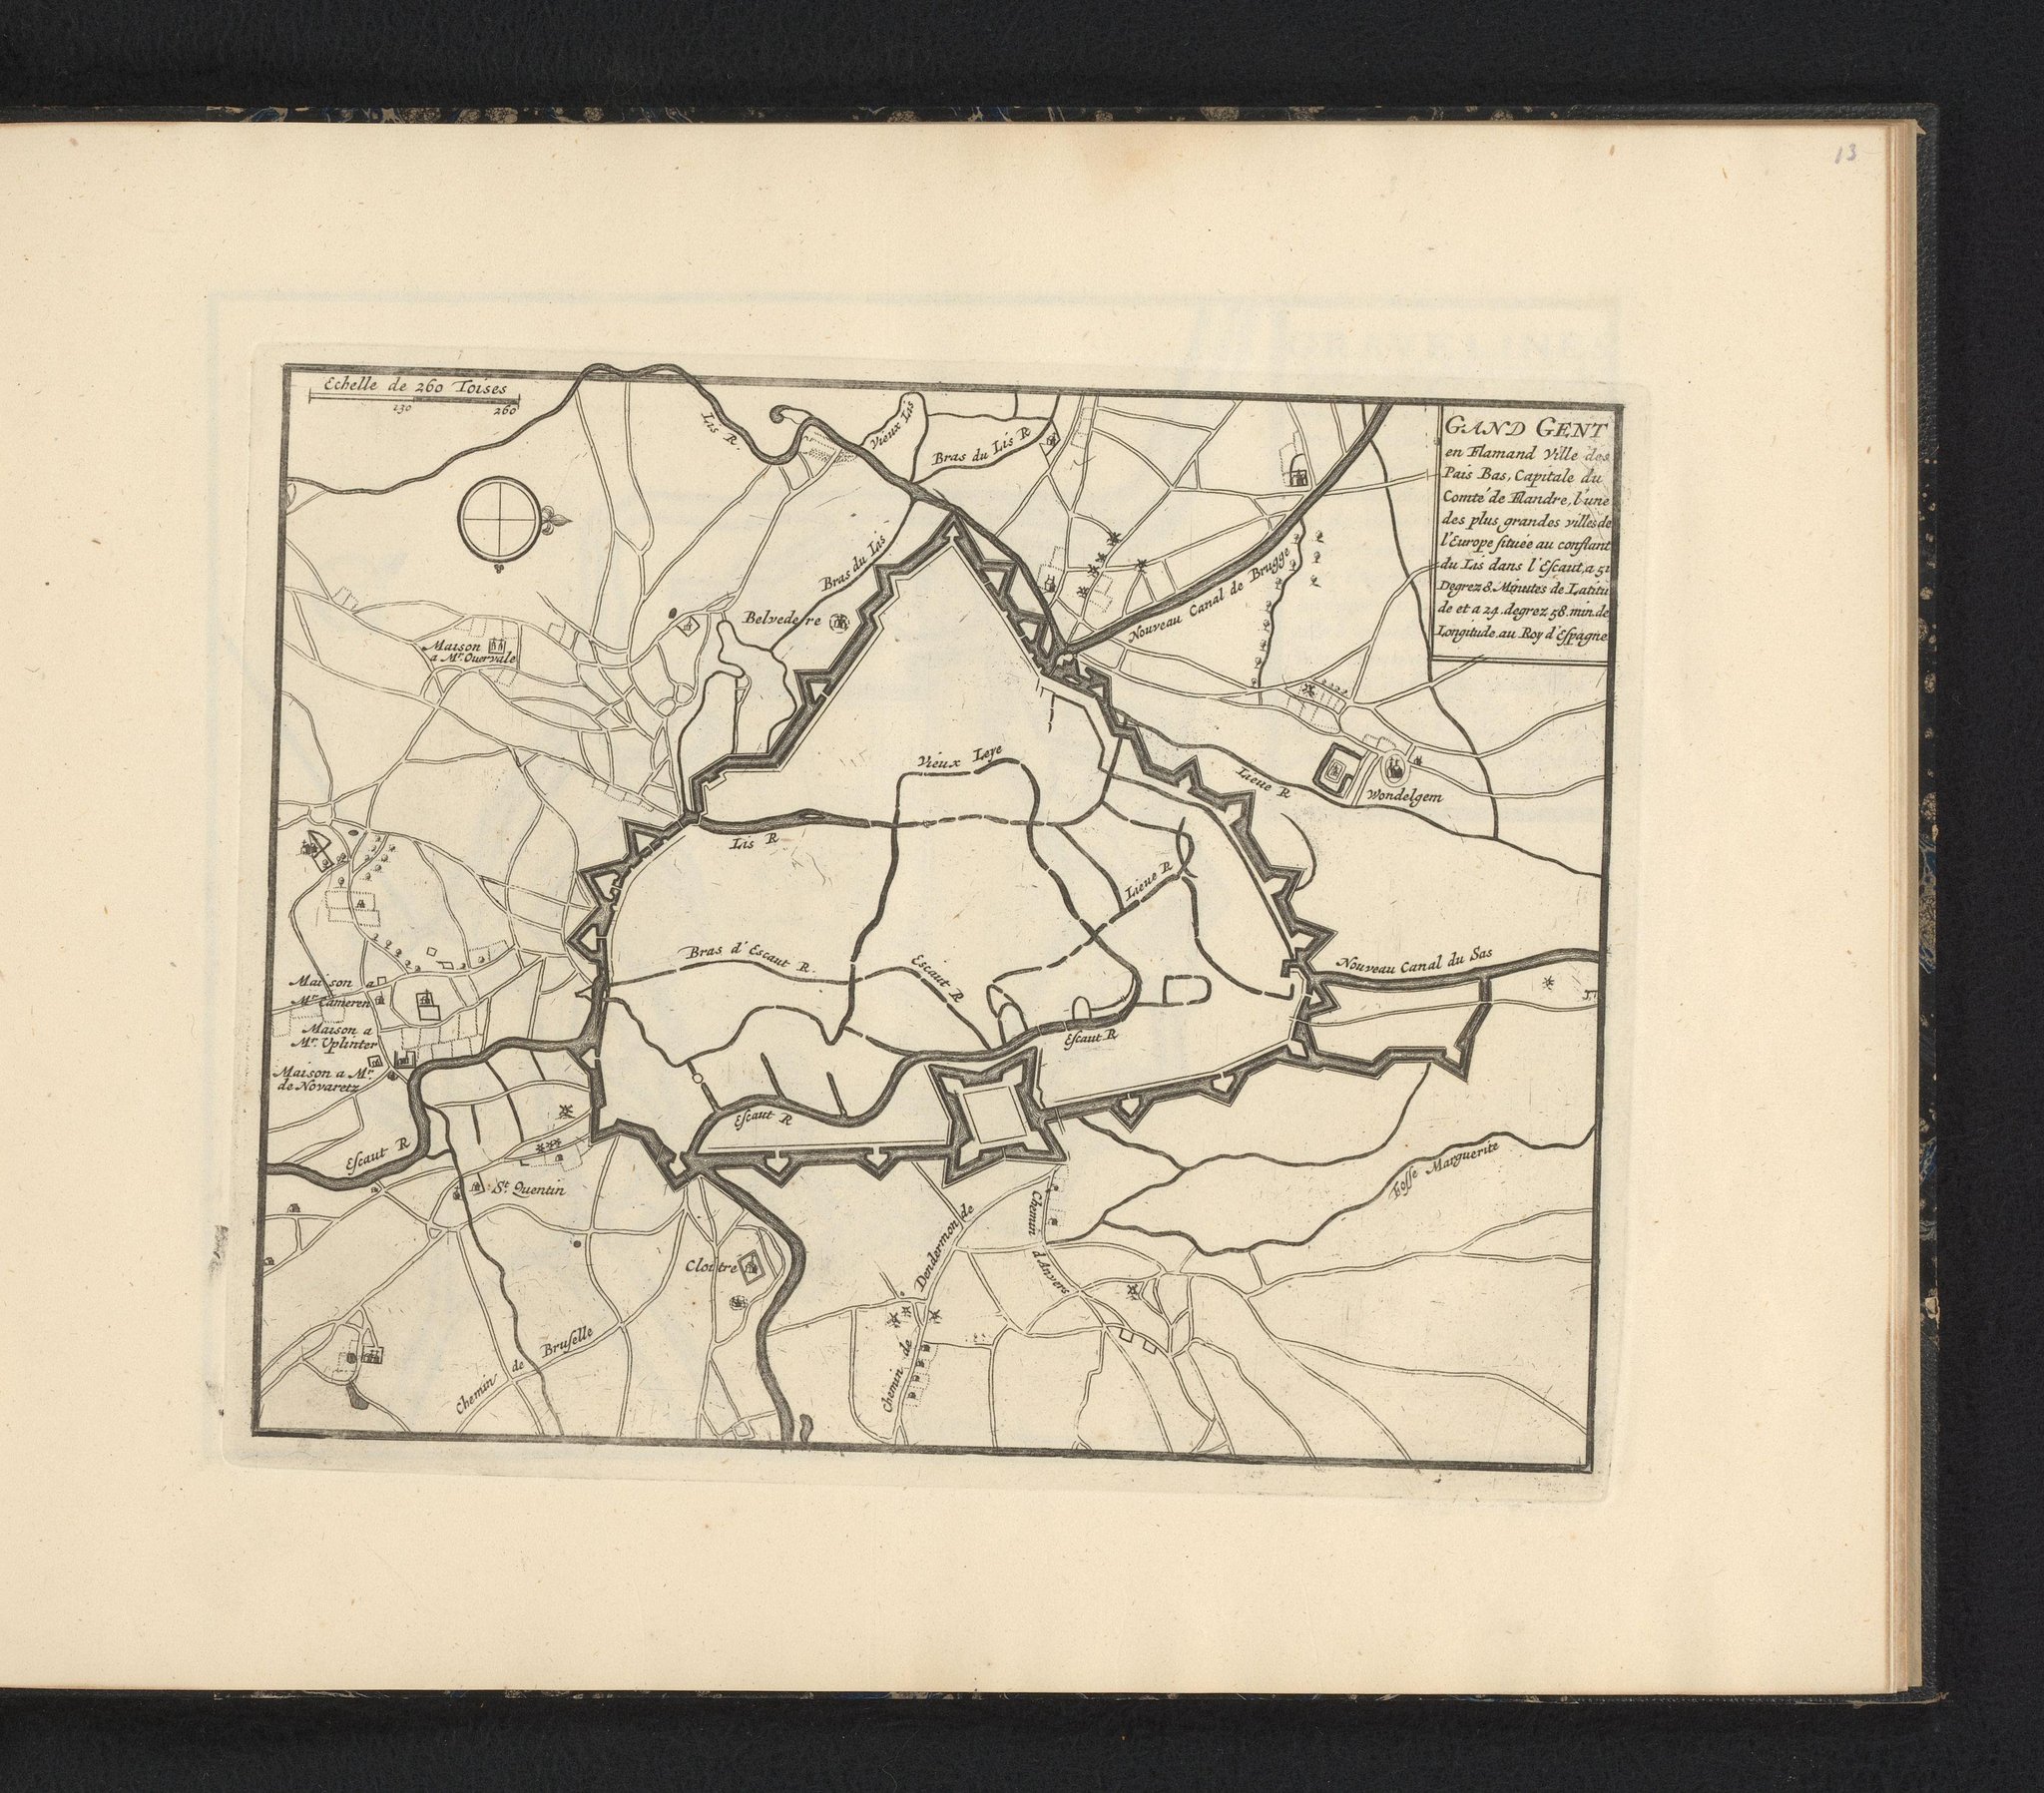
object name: map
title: Plattegrond van Gent, ca. 1693-1696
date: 1693-1696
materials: paper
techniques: etching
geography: paris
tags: fortress, maps of cities, ghent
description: Plattegrond van de versterkingen om de Vlaamse stad Gent. Maakt deel uit van het eerste deel van het prentwerk: Le Theatre de la Guerre, dans les Pays-Bas, uitgegeven in 1696. Dit deel bevat 25 platen met plannen (afkomstig van Sébastien Le Prestre, Seigneur de Vauban) van vermaarde sterke steden en vestingen in de Negenjarige Oorlog in de Nederlanden. Titel en opschriften in het Frans.